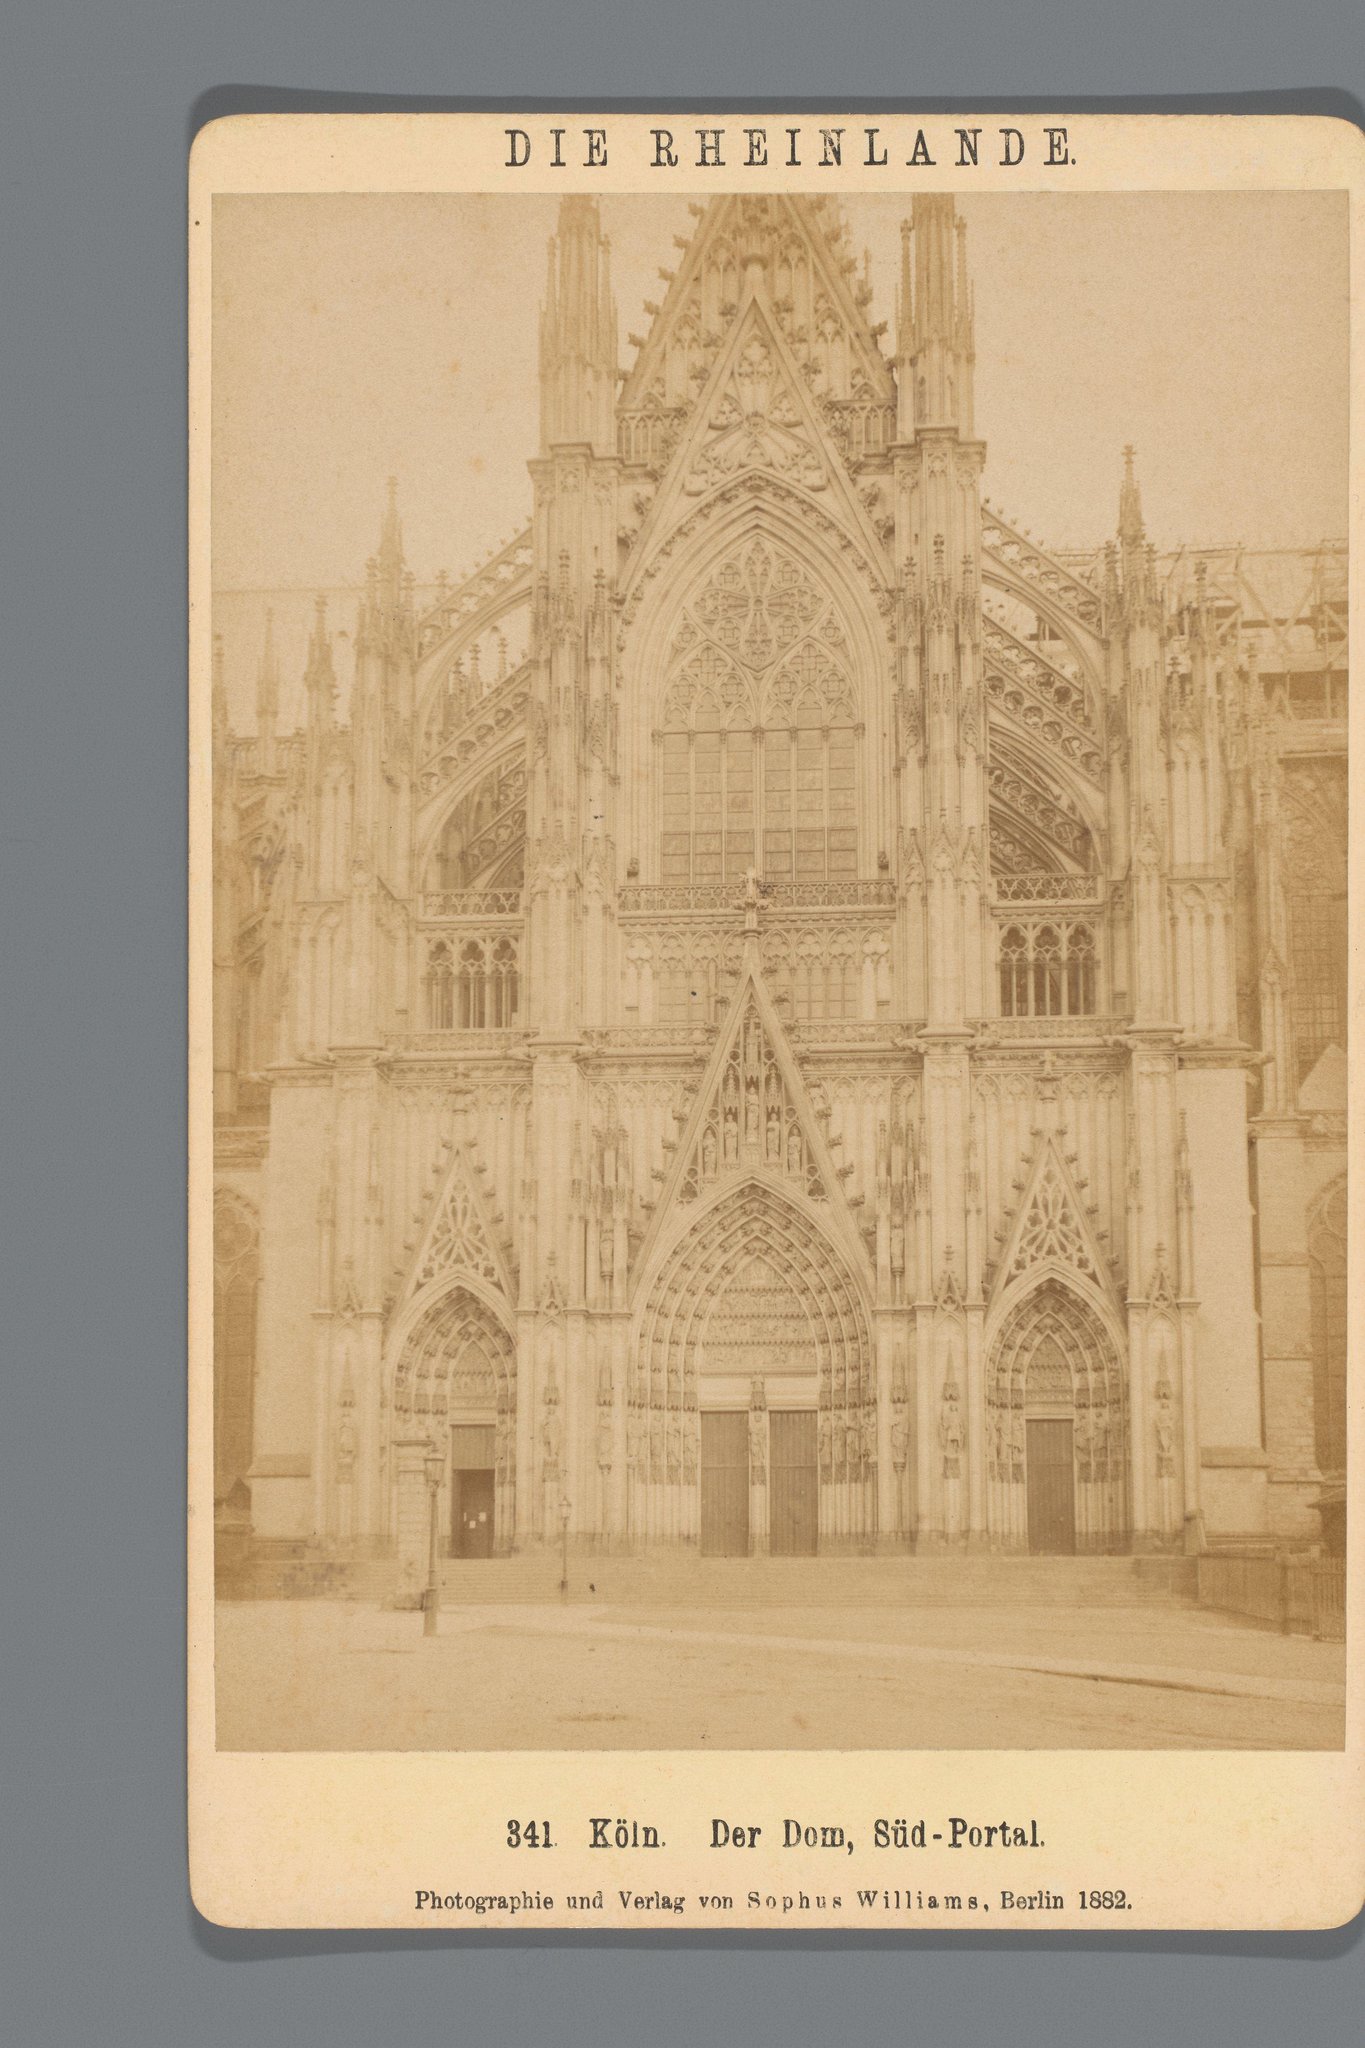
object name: photograph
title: Köln. Domkloster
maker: Anonymous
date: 1850-1880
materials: photographic support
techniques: albumen print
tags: dom van keulen